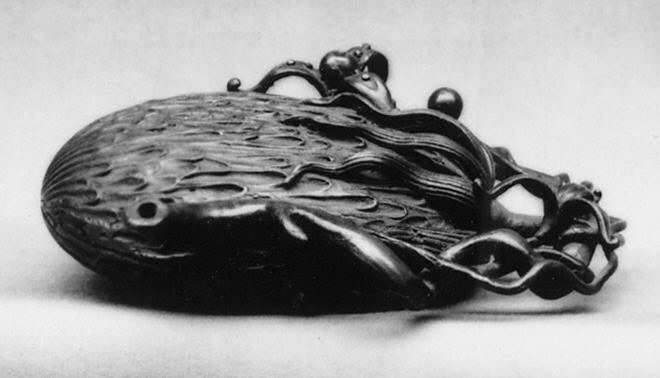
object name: ornament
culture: japanese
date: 1801-1900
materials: bronze